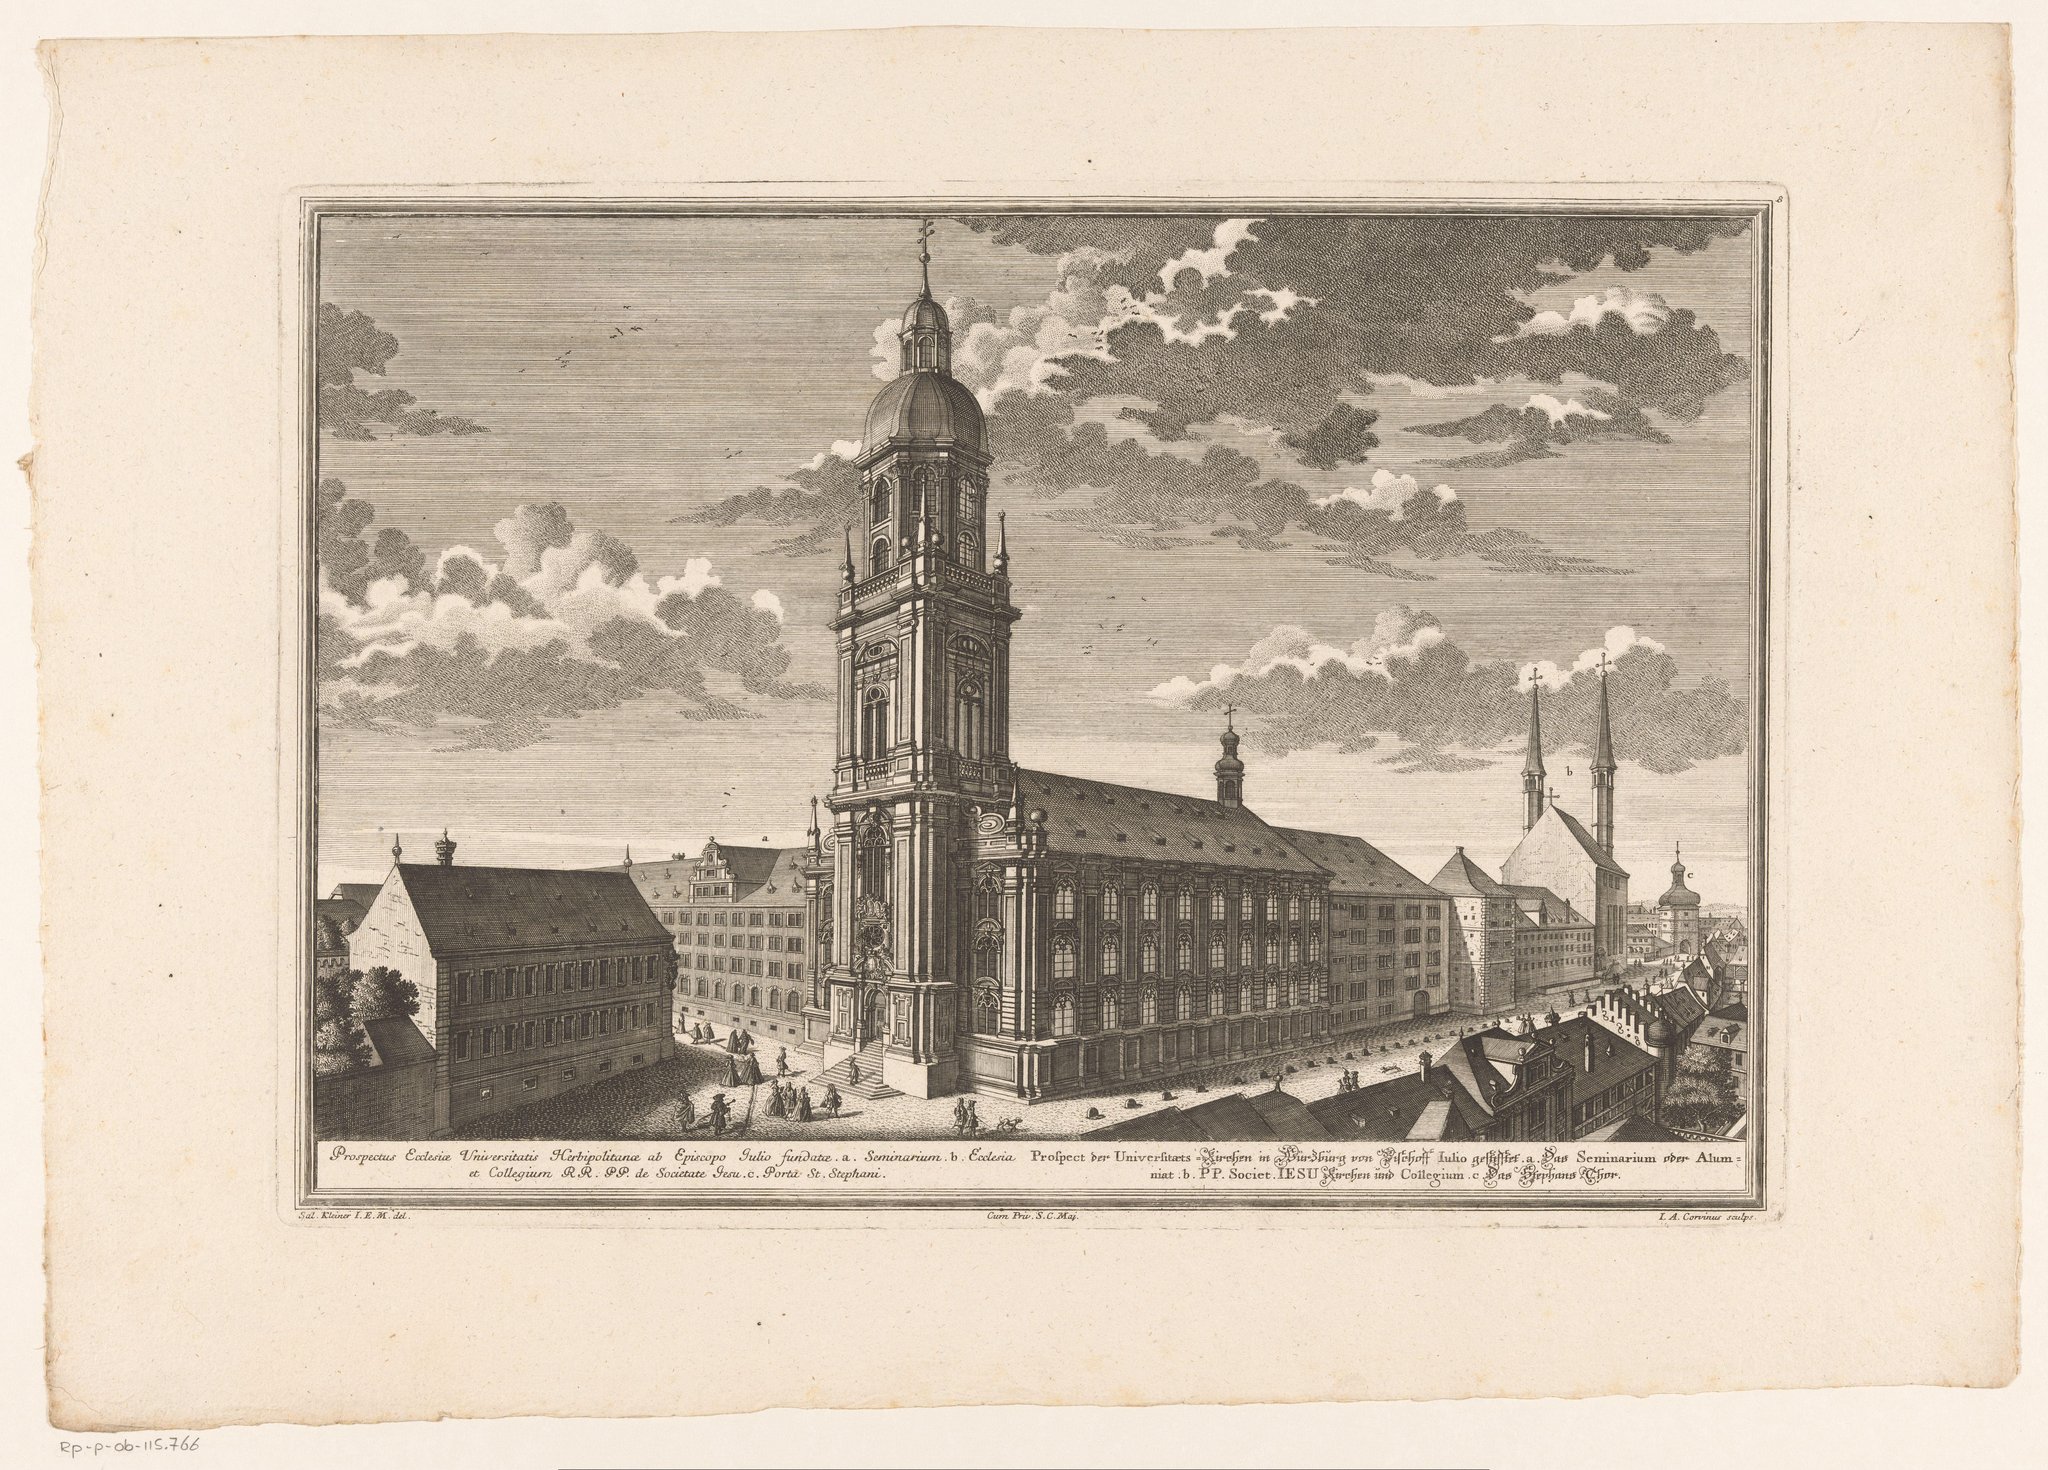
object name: print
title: Gezicht op de Neubaukirche in Würzburg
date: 1740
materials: paper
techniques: engraving, etching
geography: holy roman empire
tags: the place of worship and its equipment ~ christian churches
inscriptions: collector's mark: Lugt 2228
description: Serie bestaande uit elf prenten plus een titelprent. Johann Andreas Pfeffel wordt op de titelprent aangeduid als prentmaker, maar zijn naam staat op de prenten niet vermeld.